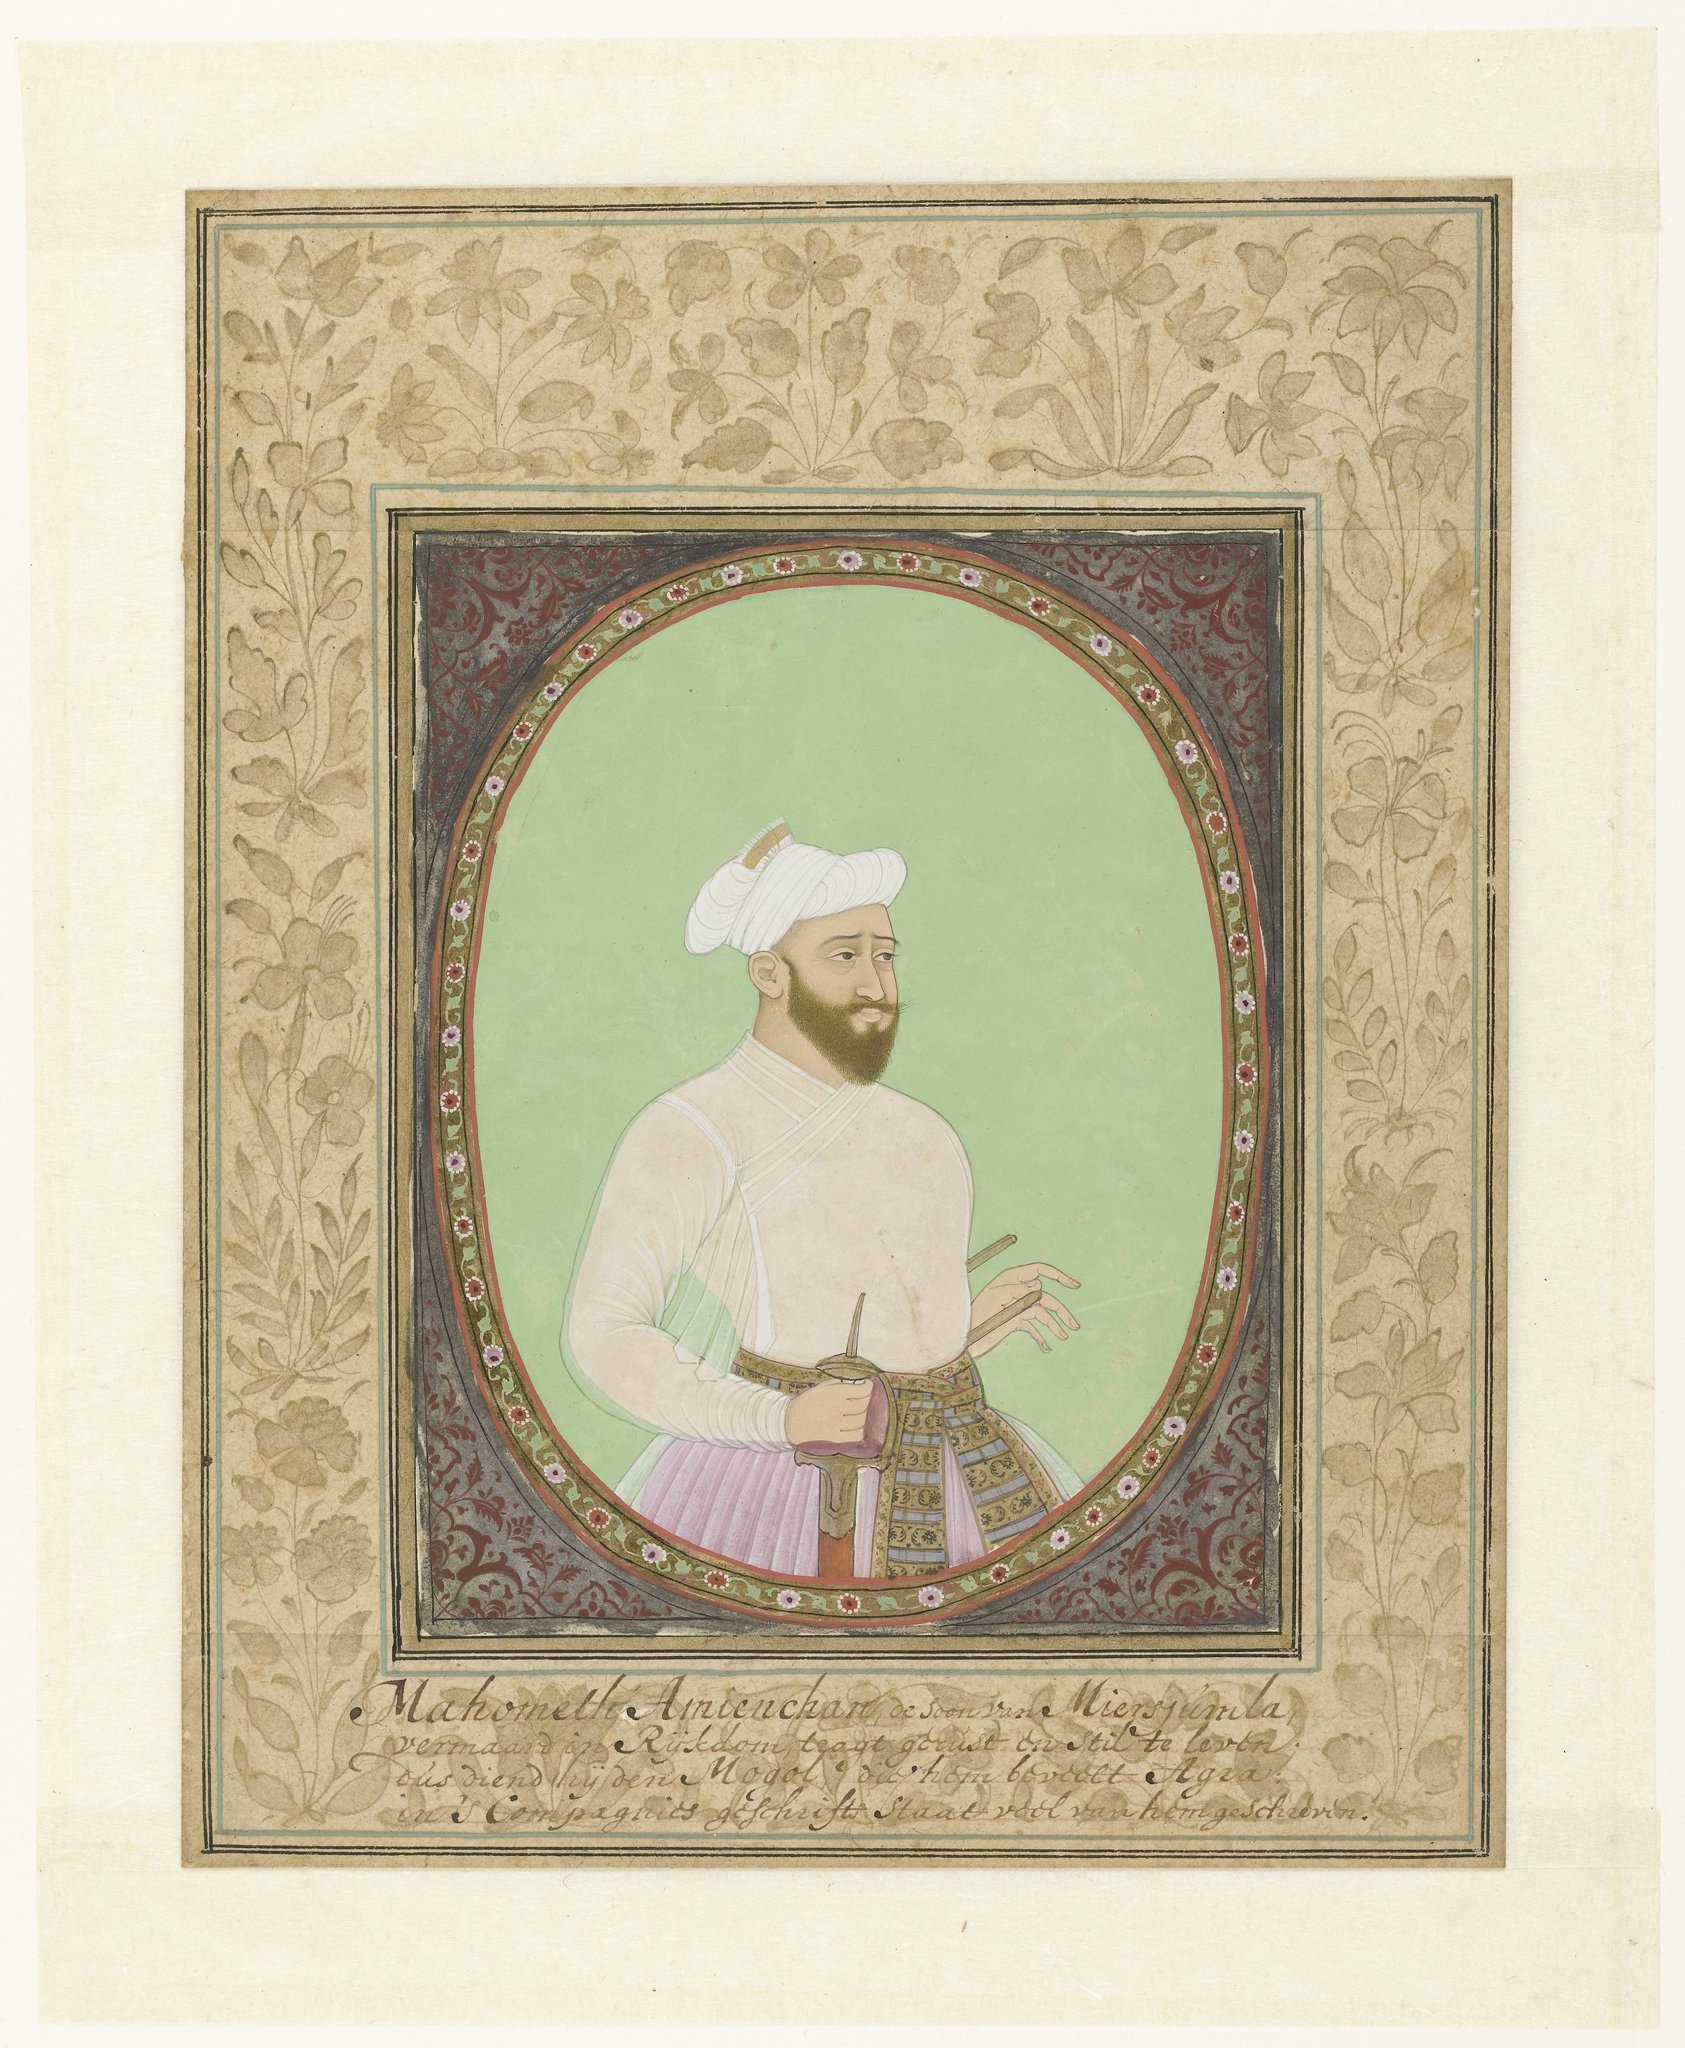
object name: indian miniature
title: Portret van Muhammad Amin Khan met uitvoerig Hollands onderschrift op de versierde omlijsting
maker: Anonymous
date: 1675-1685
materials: paint, gouache, paper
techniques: brush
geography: golkonda